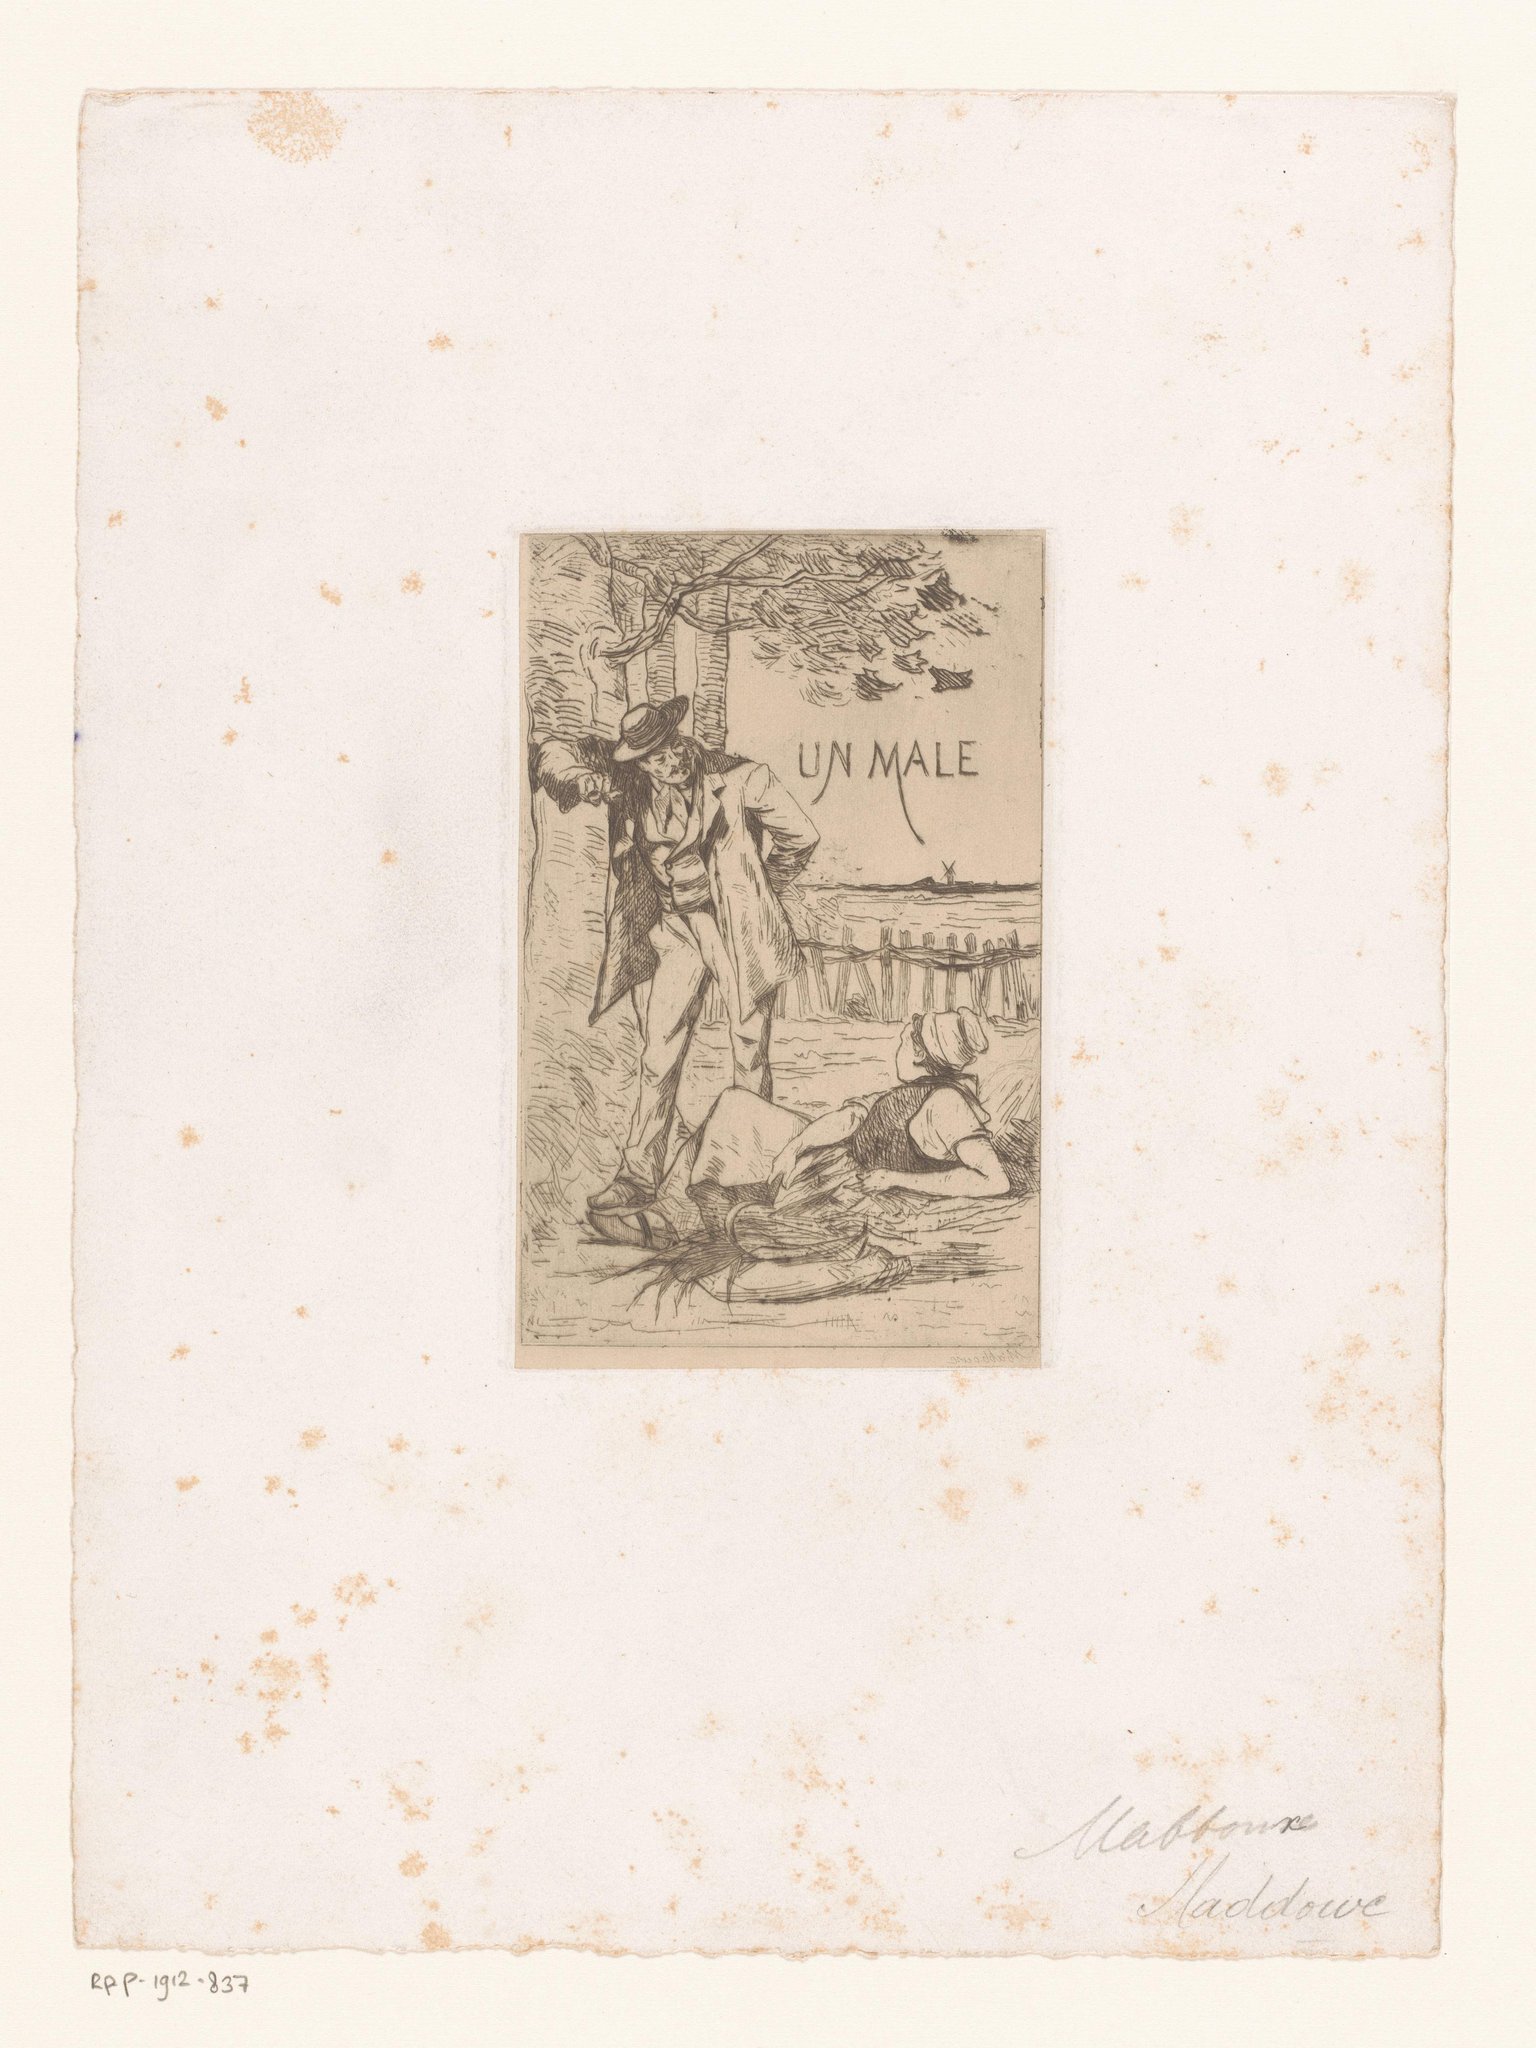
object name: print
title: Twee mannen in een landschap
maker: frédéric mabboux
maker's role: print maker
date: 1850-1899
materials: paper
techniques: etching, intaglio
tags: adult man (+ two persons), landscapes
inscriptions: collector's mark: Lugt 2228